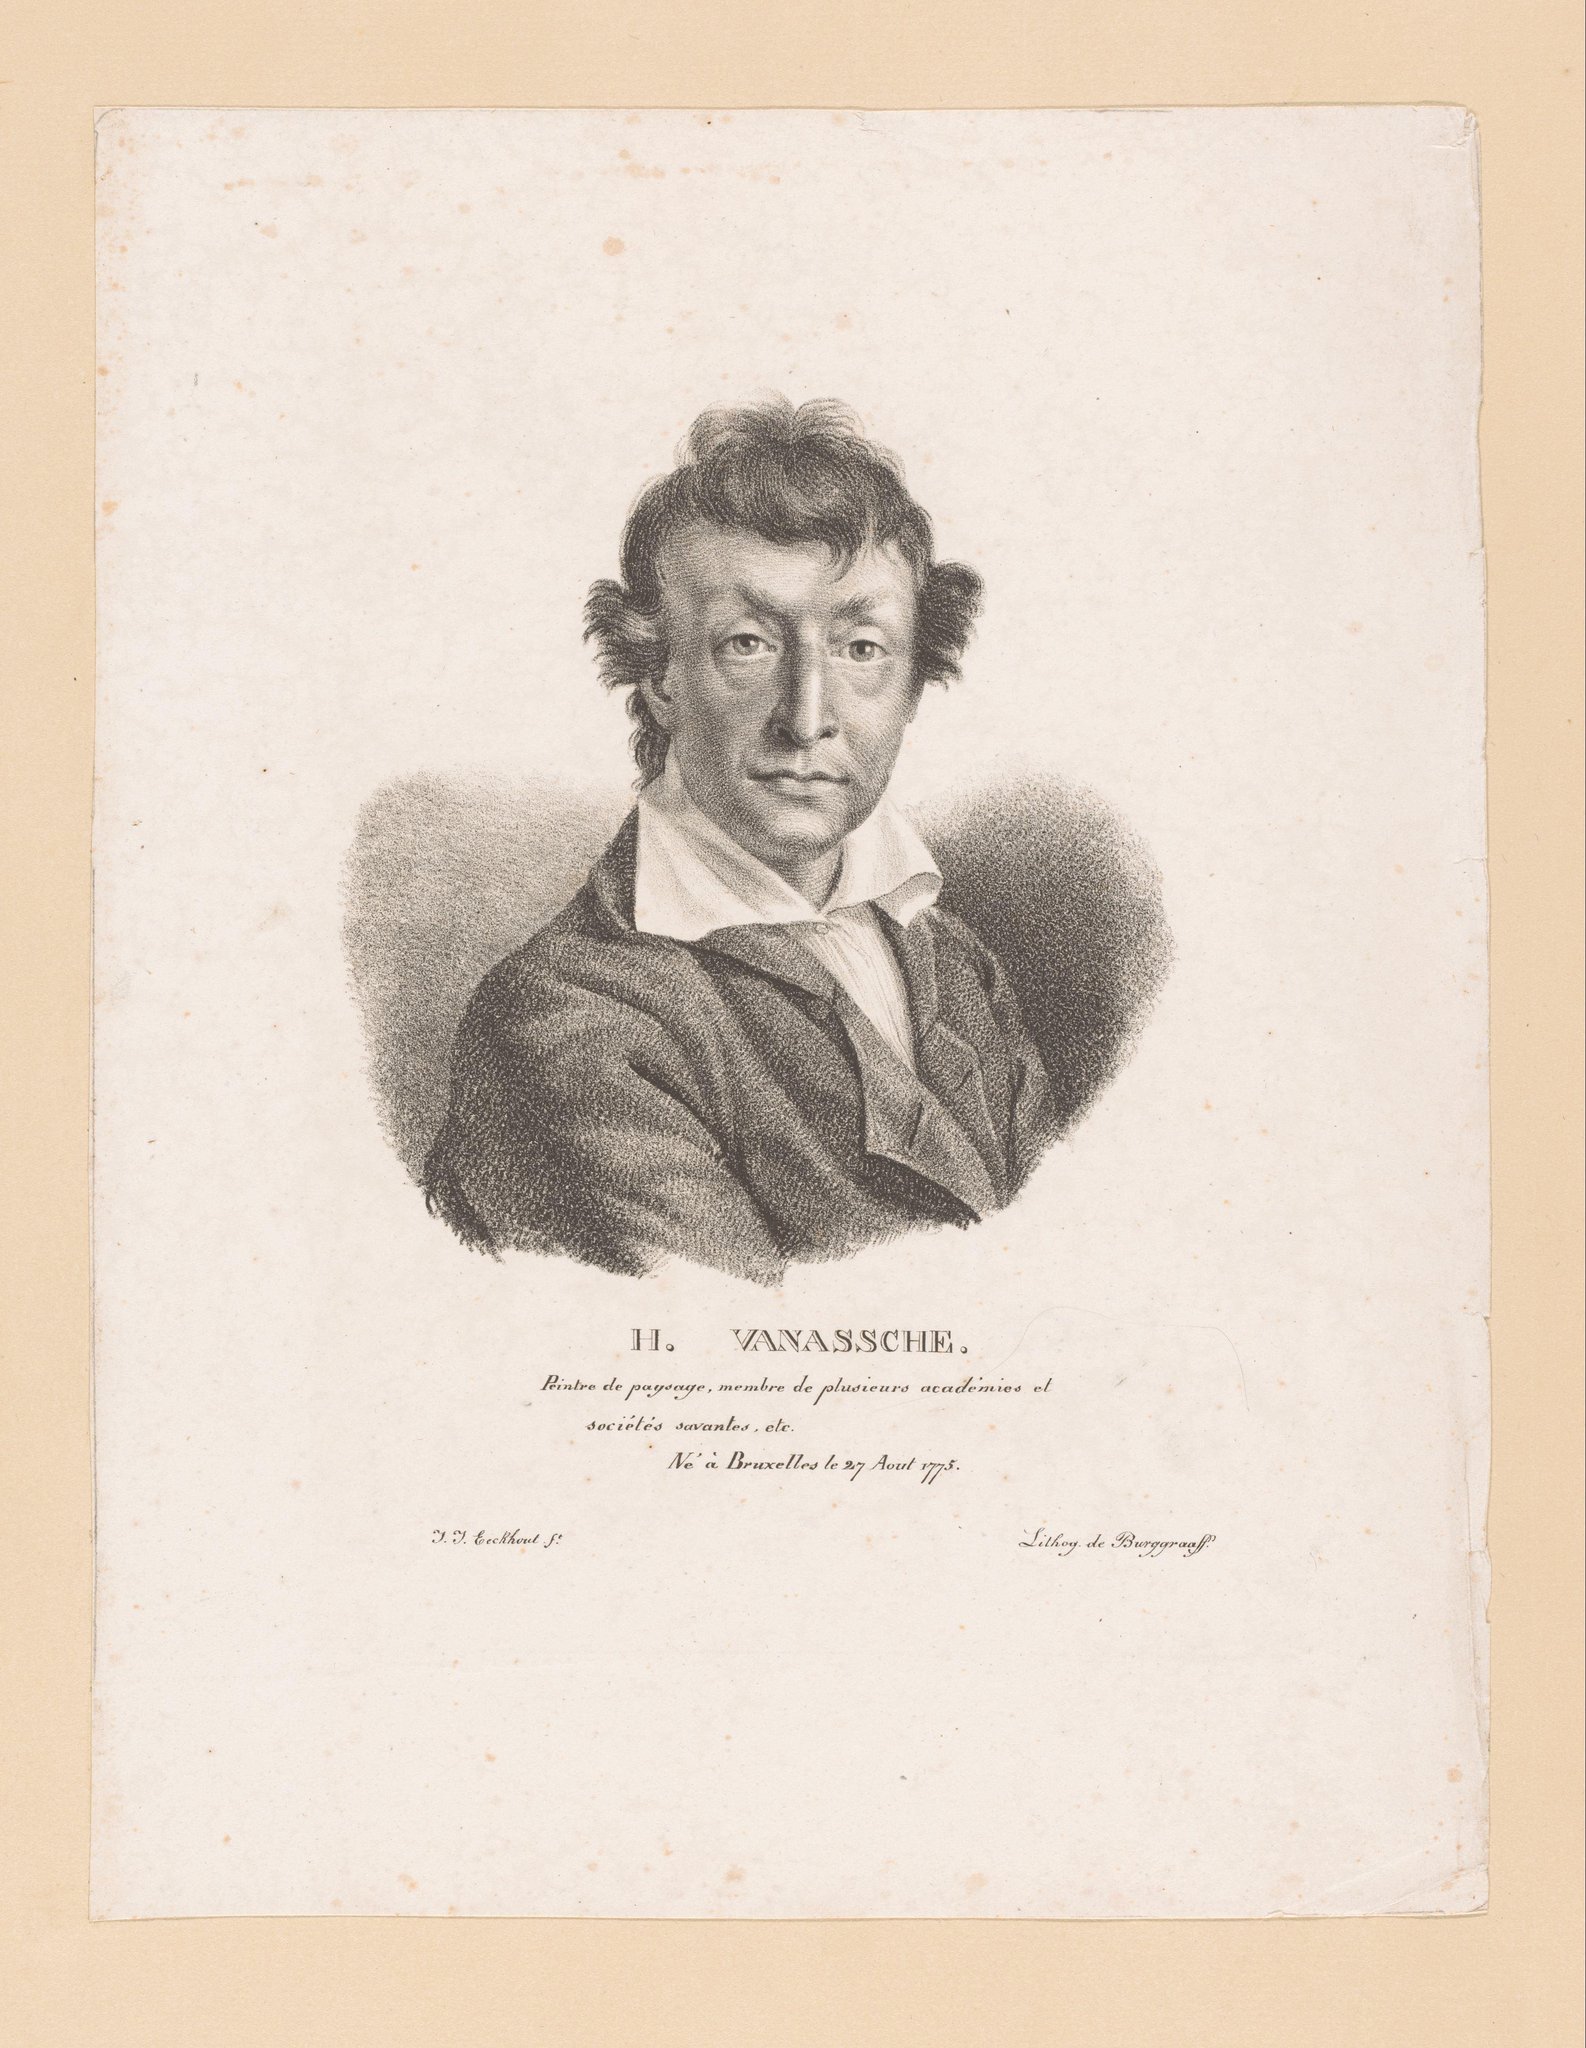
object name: print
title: Portret van Henri van Assche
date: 1822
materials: paper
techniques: lithograph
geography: brussels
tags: brussels, print maker, henri van assche, historical persons, portrait, self-portrait of graphic artist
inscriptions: collector's mark: Lugt 2228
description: Prent maakt deel uit van een serie van zestig prenten.